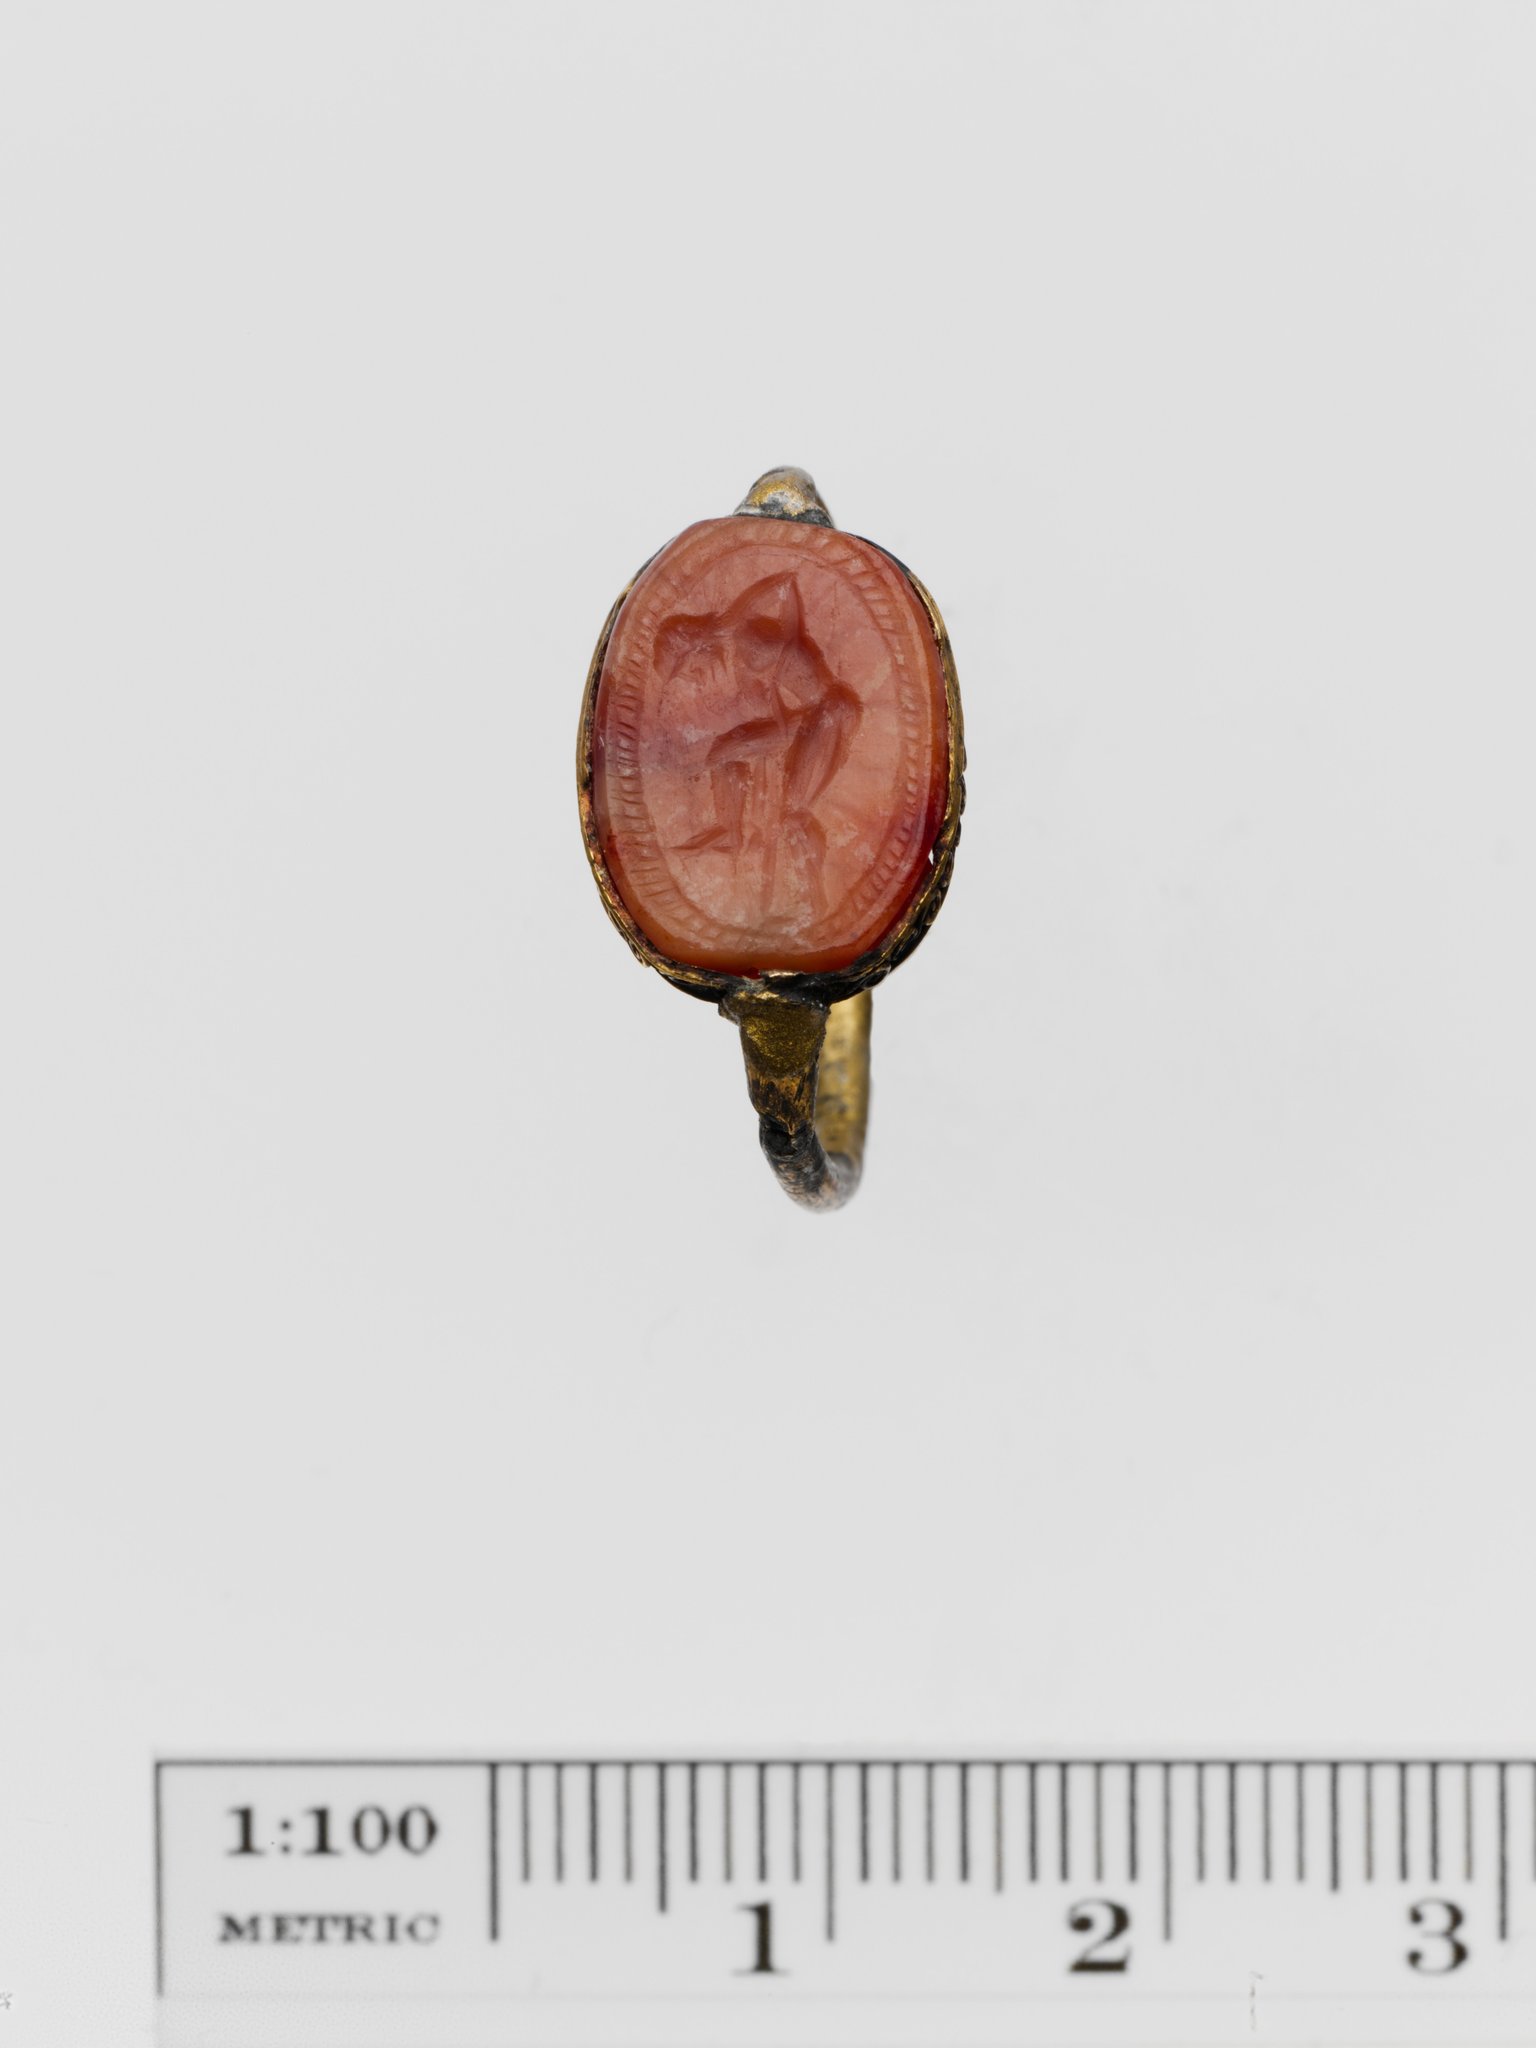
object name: ring with scarab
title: Carnelian scarab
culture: greek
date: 534-501 BCE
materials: gemstone, gold